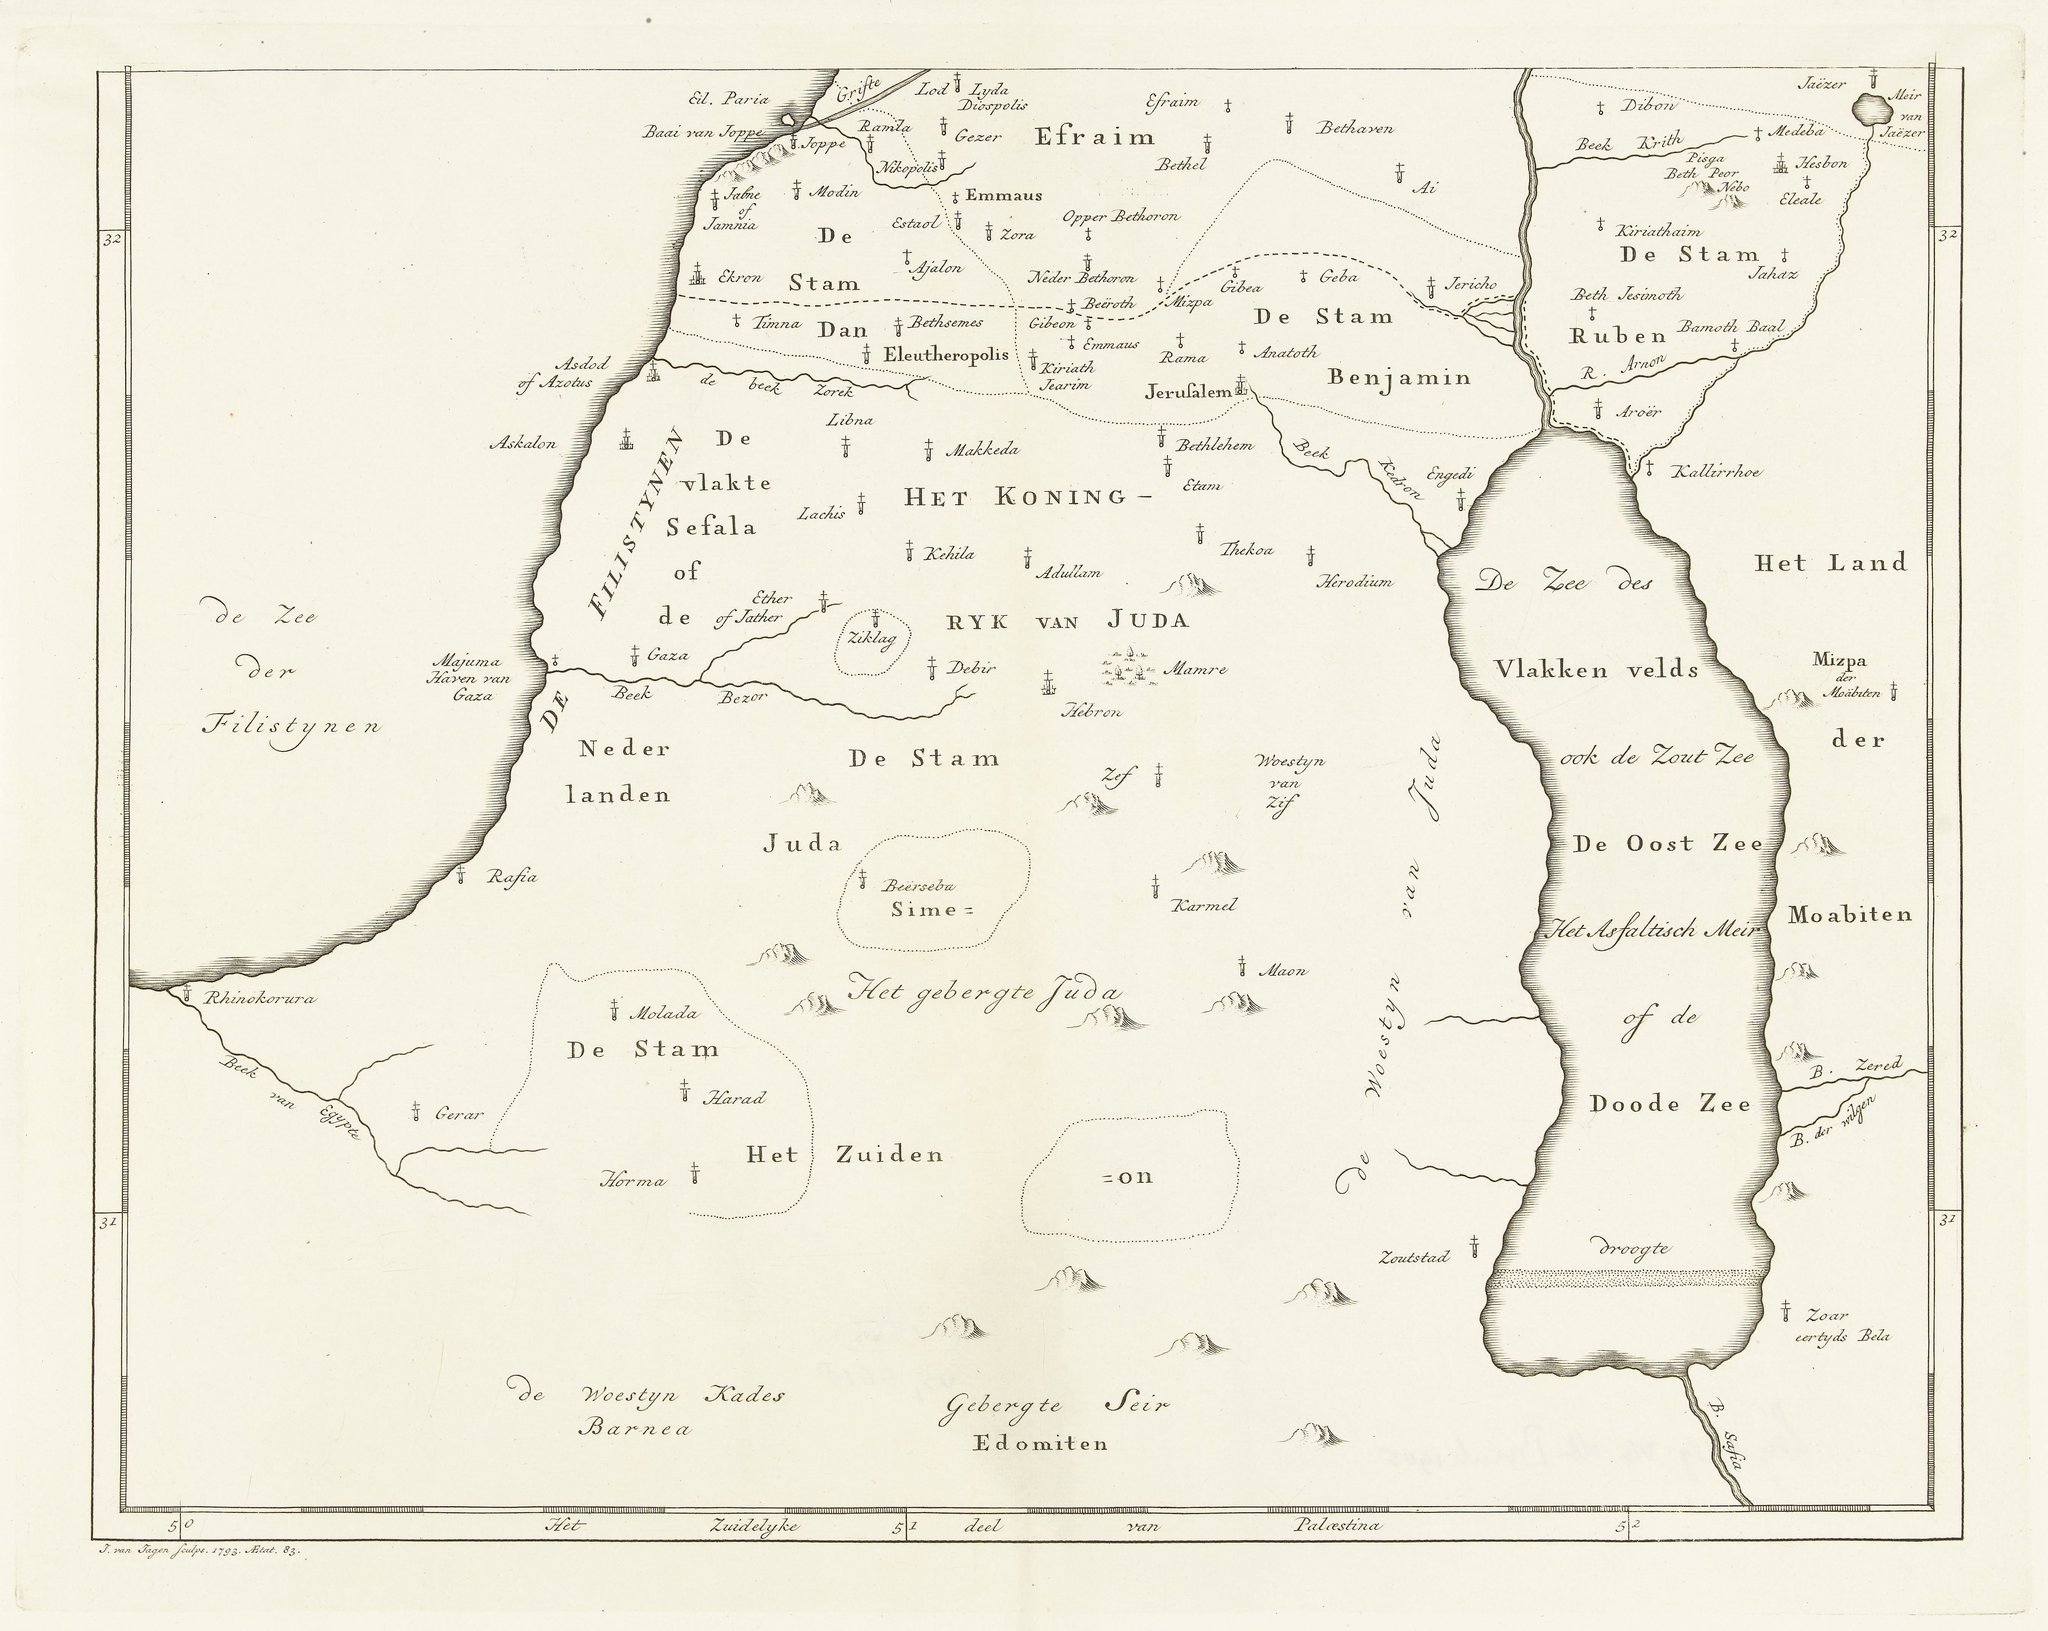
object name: print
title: Kaart van het zuidelijke deel van Palestina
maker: jan van jagen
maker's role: print maker, publisher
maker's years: 1709-1800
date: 1793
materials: paper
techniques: engraving, etching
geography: amsterdam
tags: maps of separate countries or regions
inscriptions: collector's mark: Lugt 2228